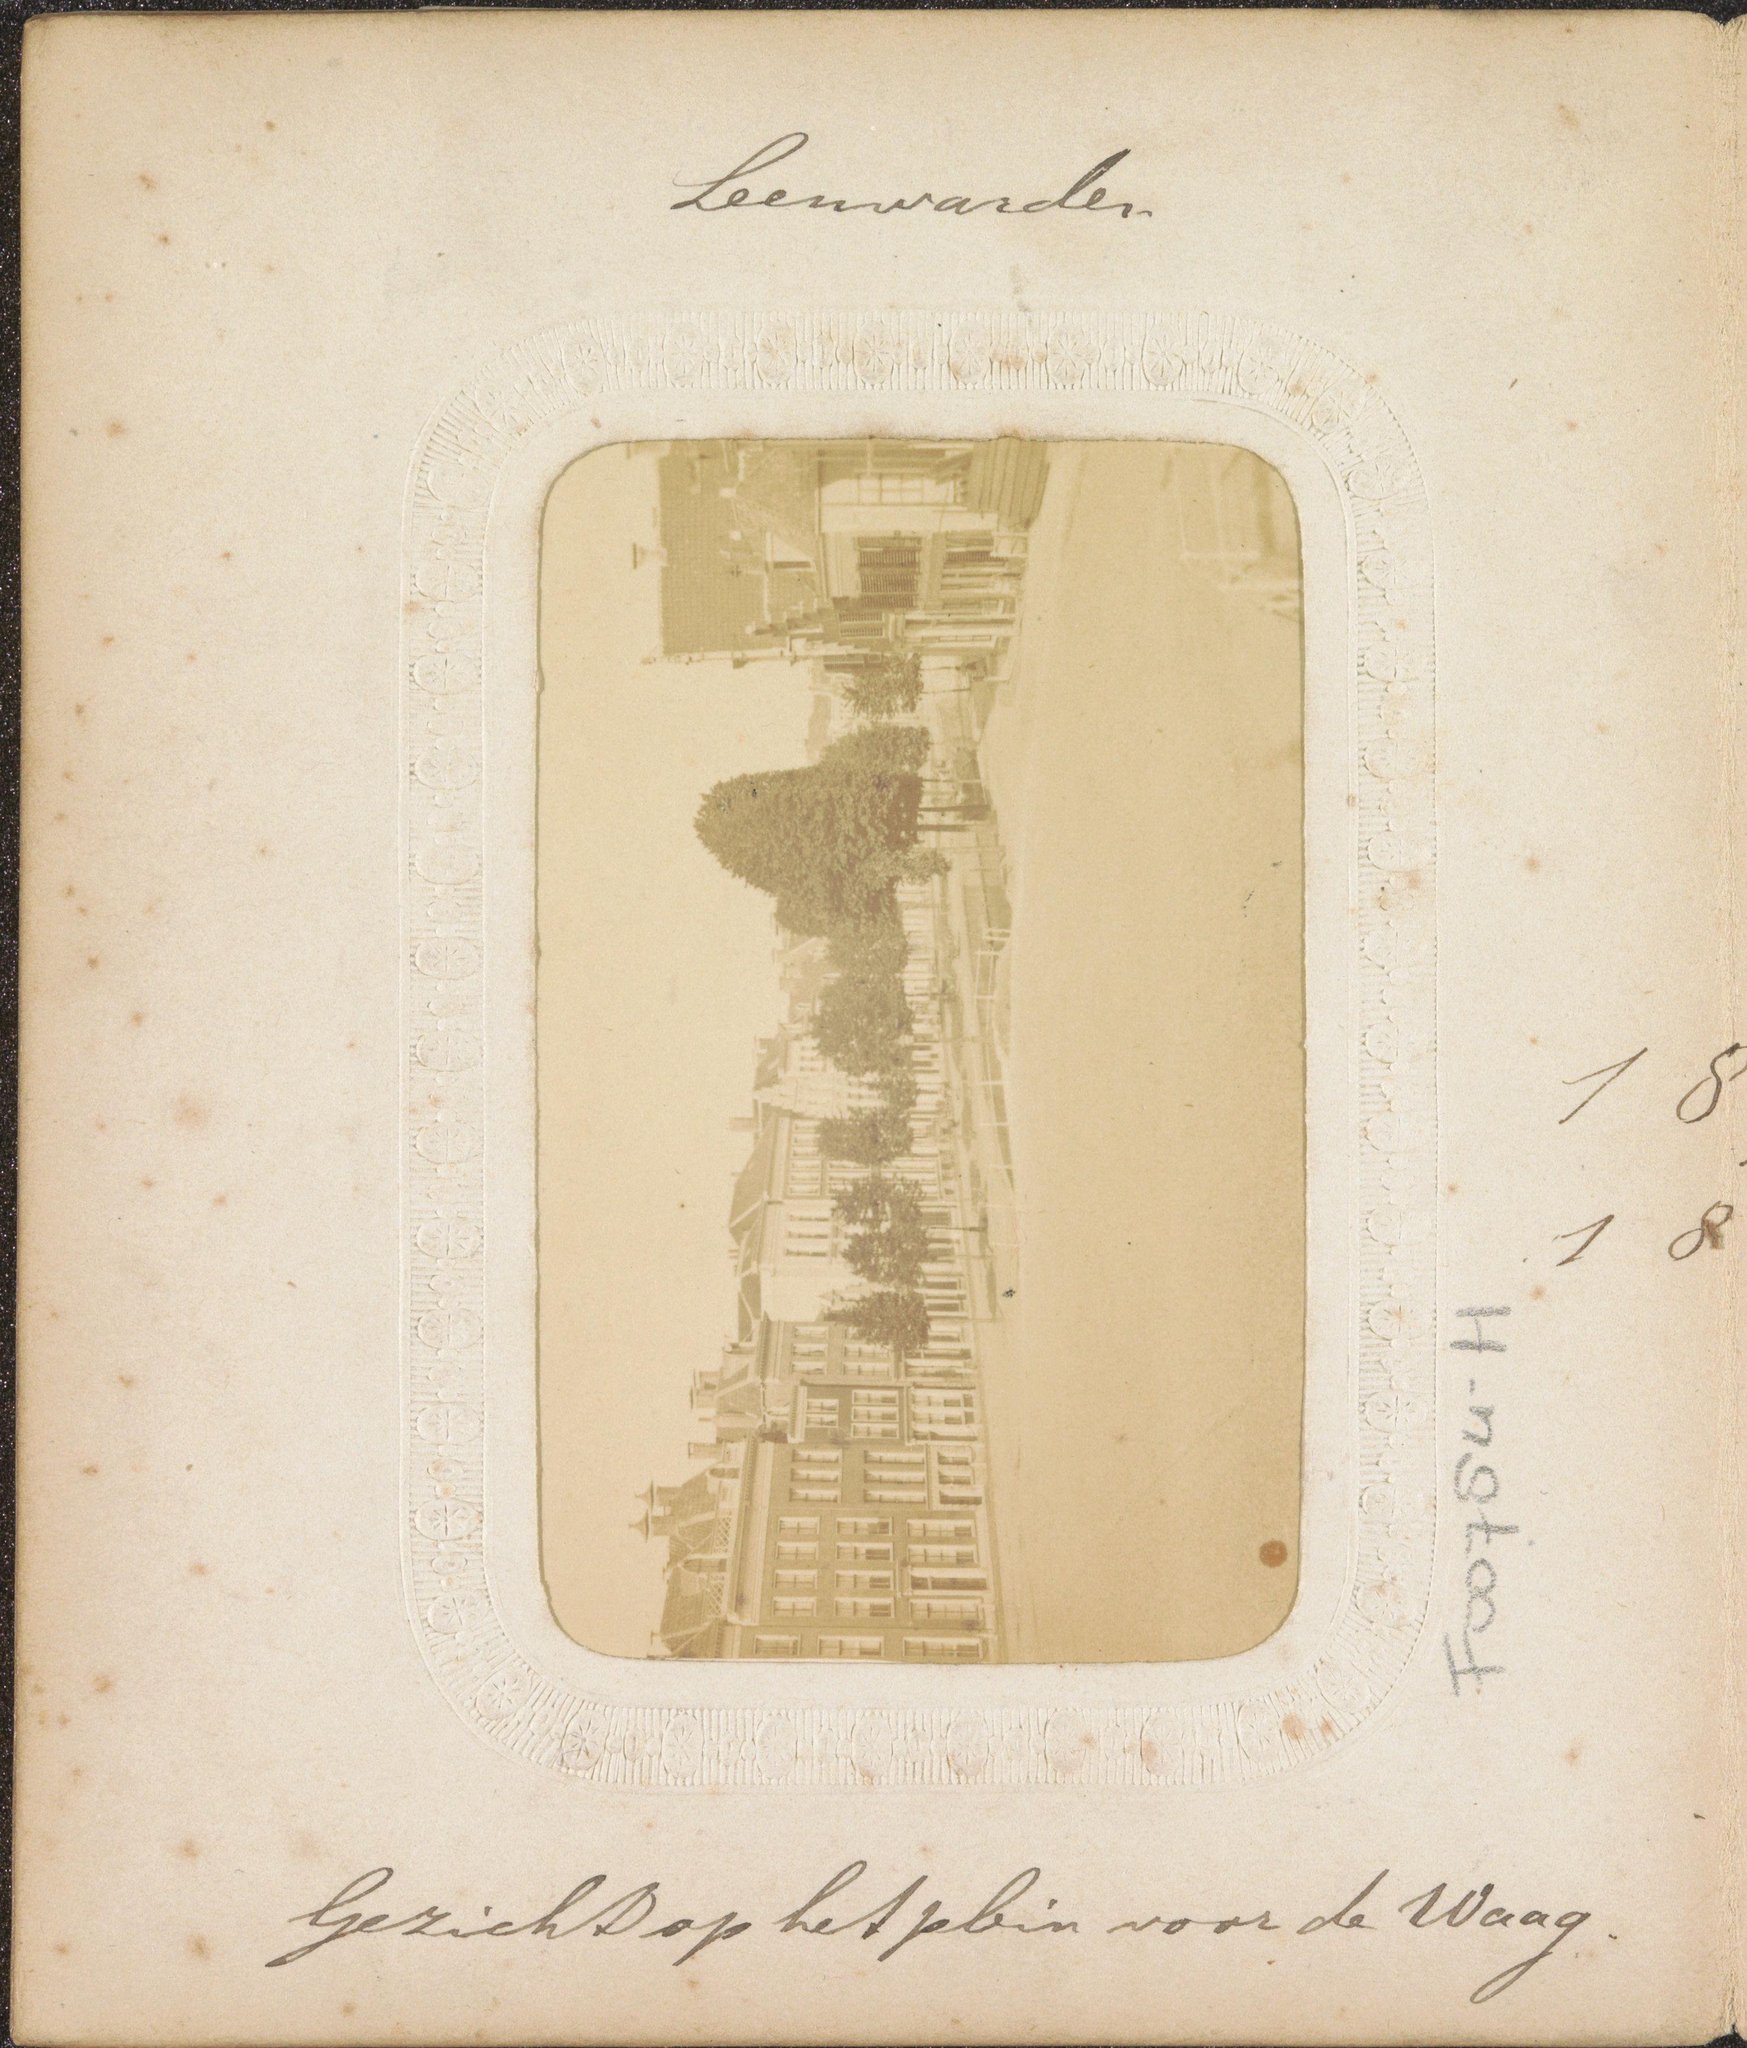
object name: album leaf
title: Leeuwarden, gezicht op het plein voor de Waag.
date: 1870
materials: cardboard, paper, photographic support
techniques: albumen print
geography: leeuwarden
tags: square, place, circus, etc. (+ city(-scape) with figures, staffage)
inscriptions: address: ‘Nieuwendijk L.330 Amsterdam’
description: Onderdeel van Fotoalbum met bezienswaardigheden in Nederlandse, Belgische en Duitse steden.